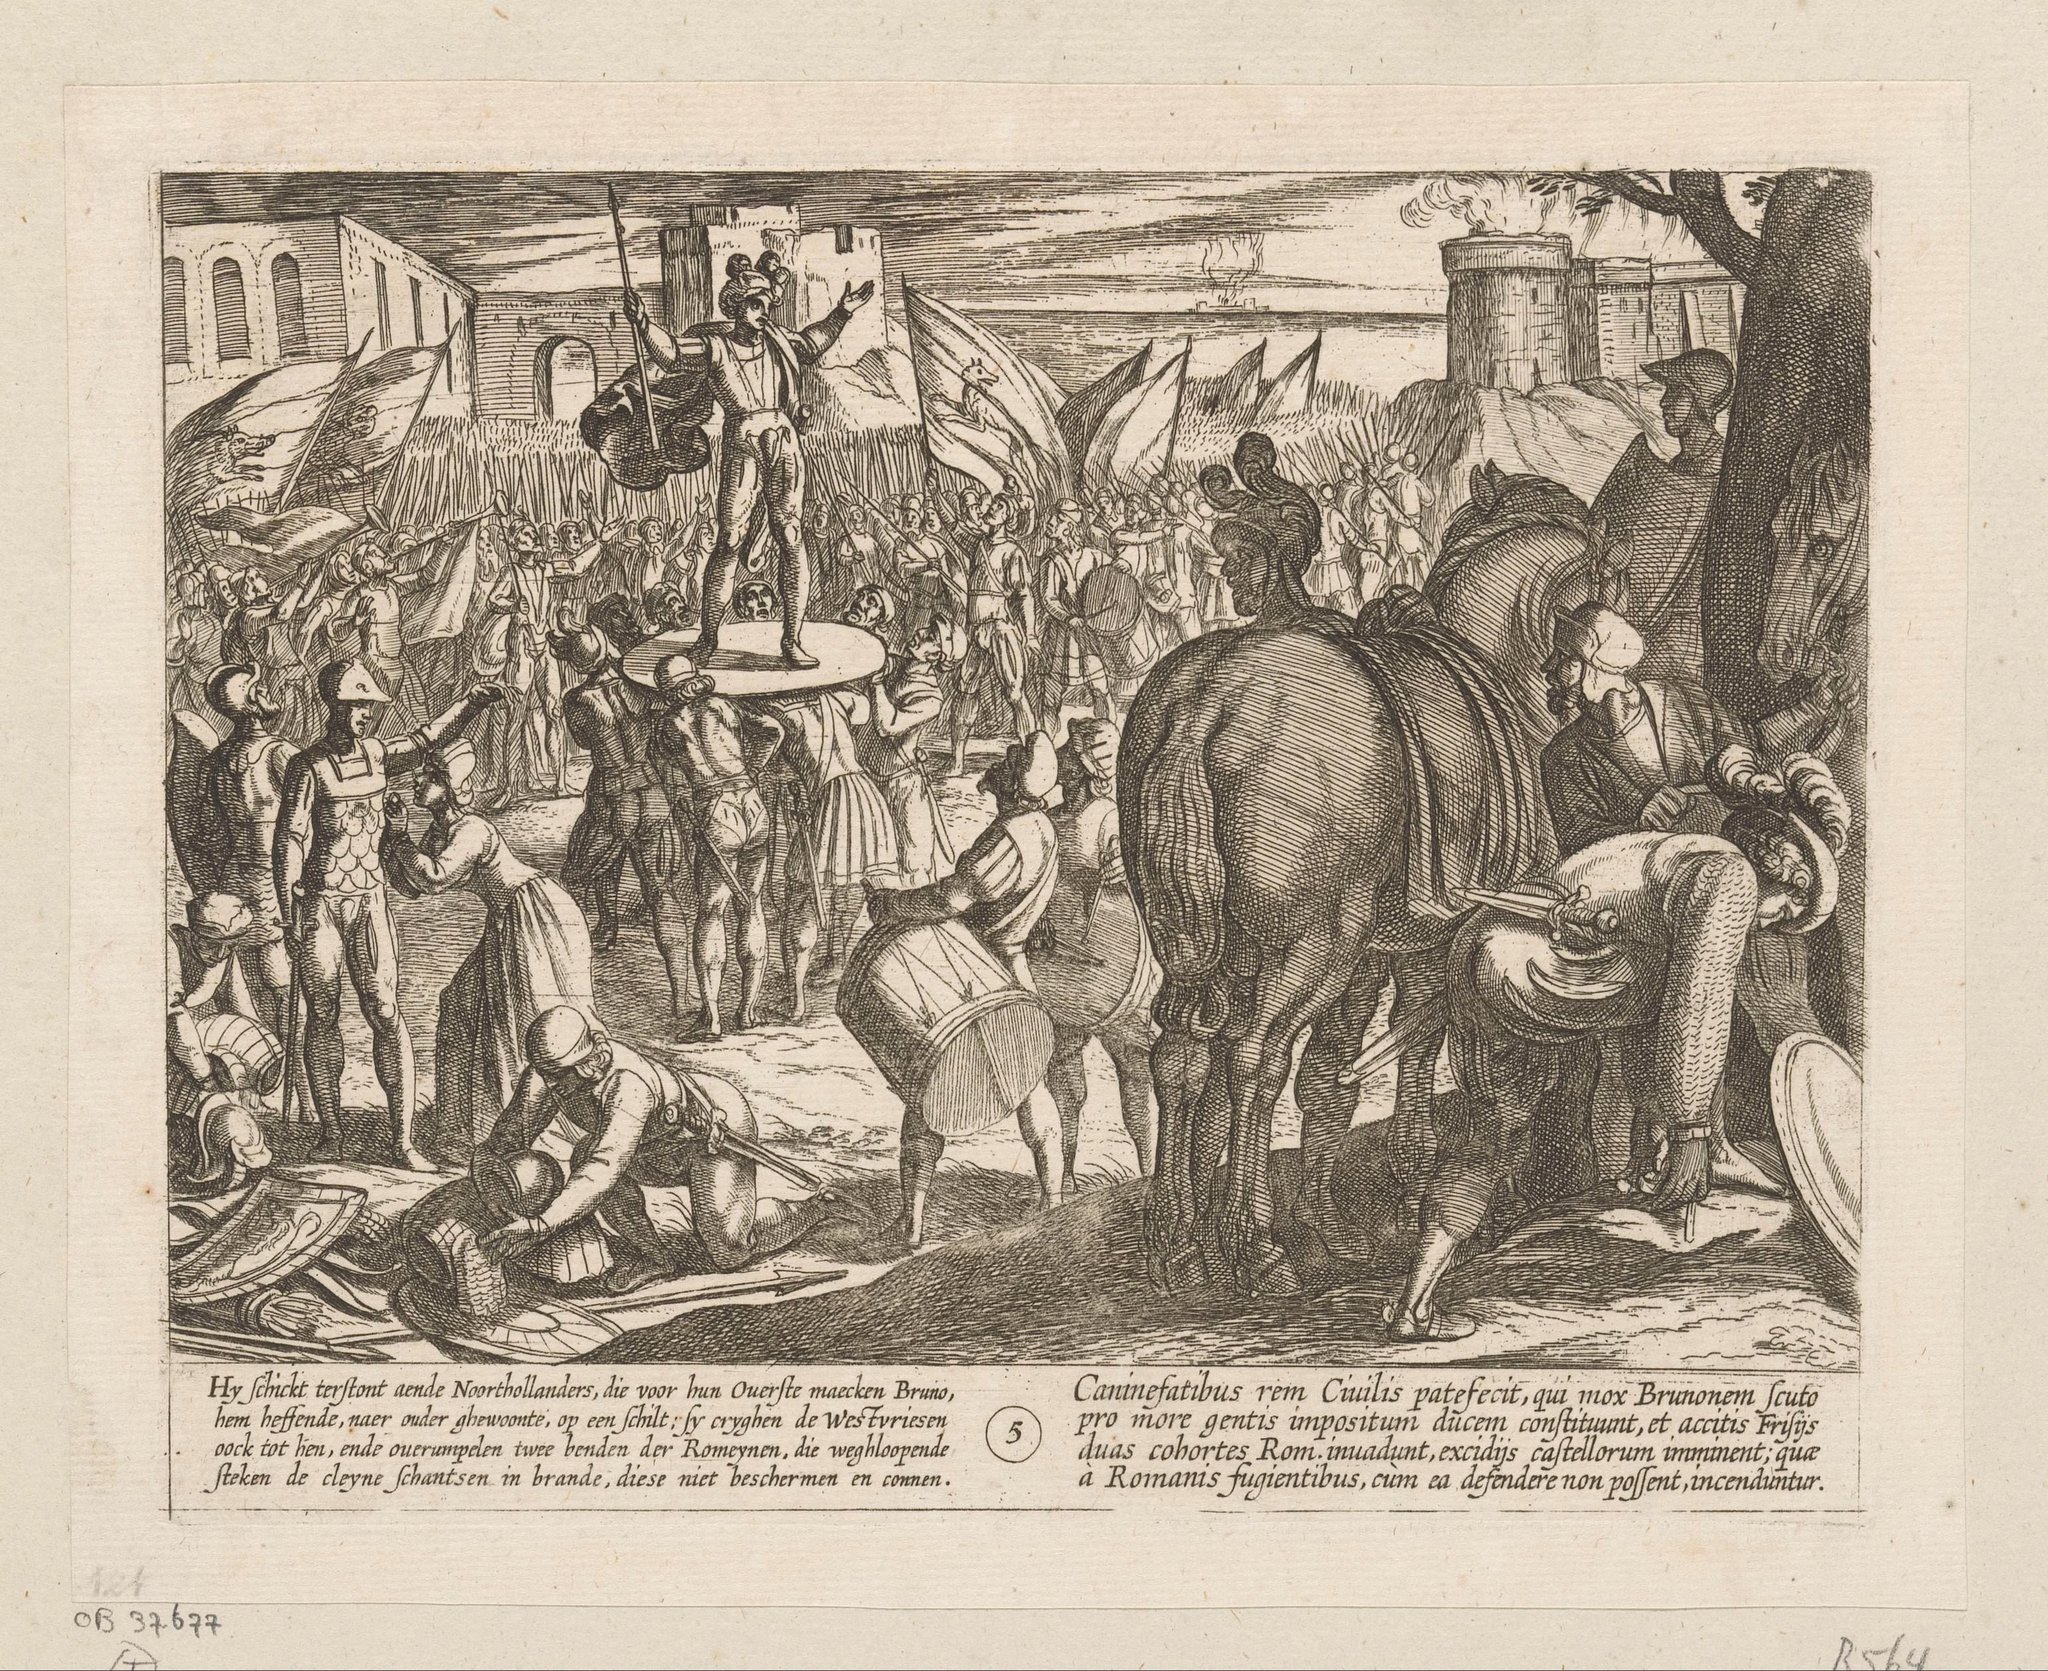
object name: history print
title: De Bataafse Opstand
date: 1612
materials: paper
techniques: etching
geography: italy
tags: brinno, extinct, 'historical' peoples (with name), netherlands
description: Brinno tot leider van de Noord-Hollanders gekozen en op een schild verheven.Twee Romeinse eenheden door de Bataven verslagen. Prent nummer 5 in de serie prenten over de Bataafse Opstand: Batavorum cum Romanis bellum / à Corn. Tacito lib. IV & V. : Hist. olim descriptum, figuris nunc aeneis expressum, auctore Othone Vaenio Lugdunobatava = De Batavische oft oude Hollandtsche oorloghe teghen de Romeynen. Otto Vaenius, Antwerpen 1612. Onderaan twee verzen van vier regels in het Nederlands en in het Latijn. Zonder tekst op achterzijde.